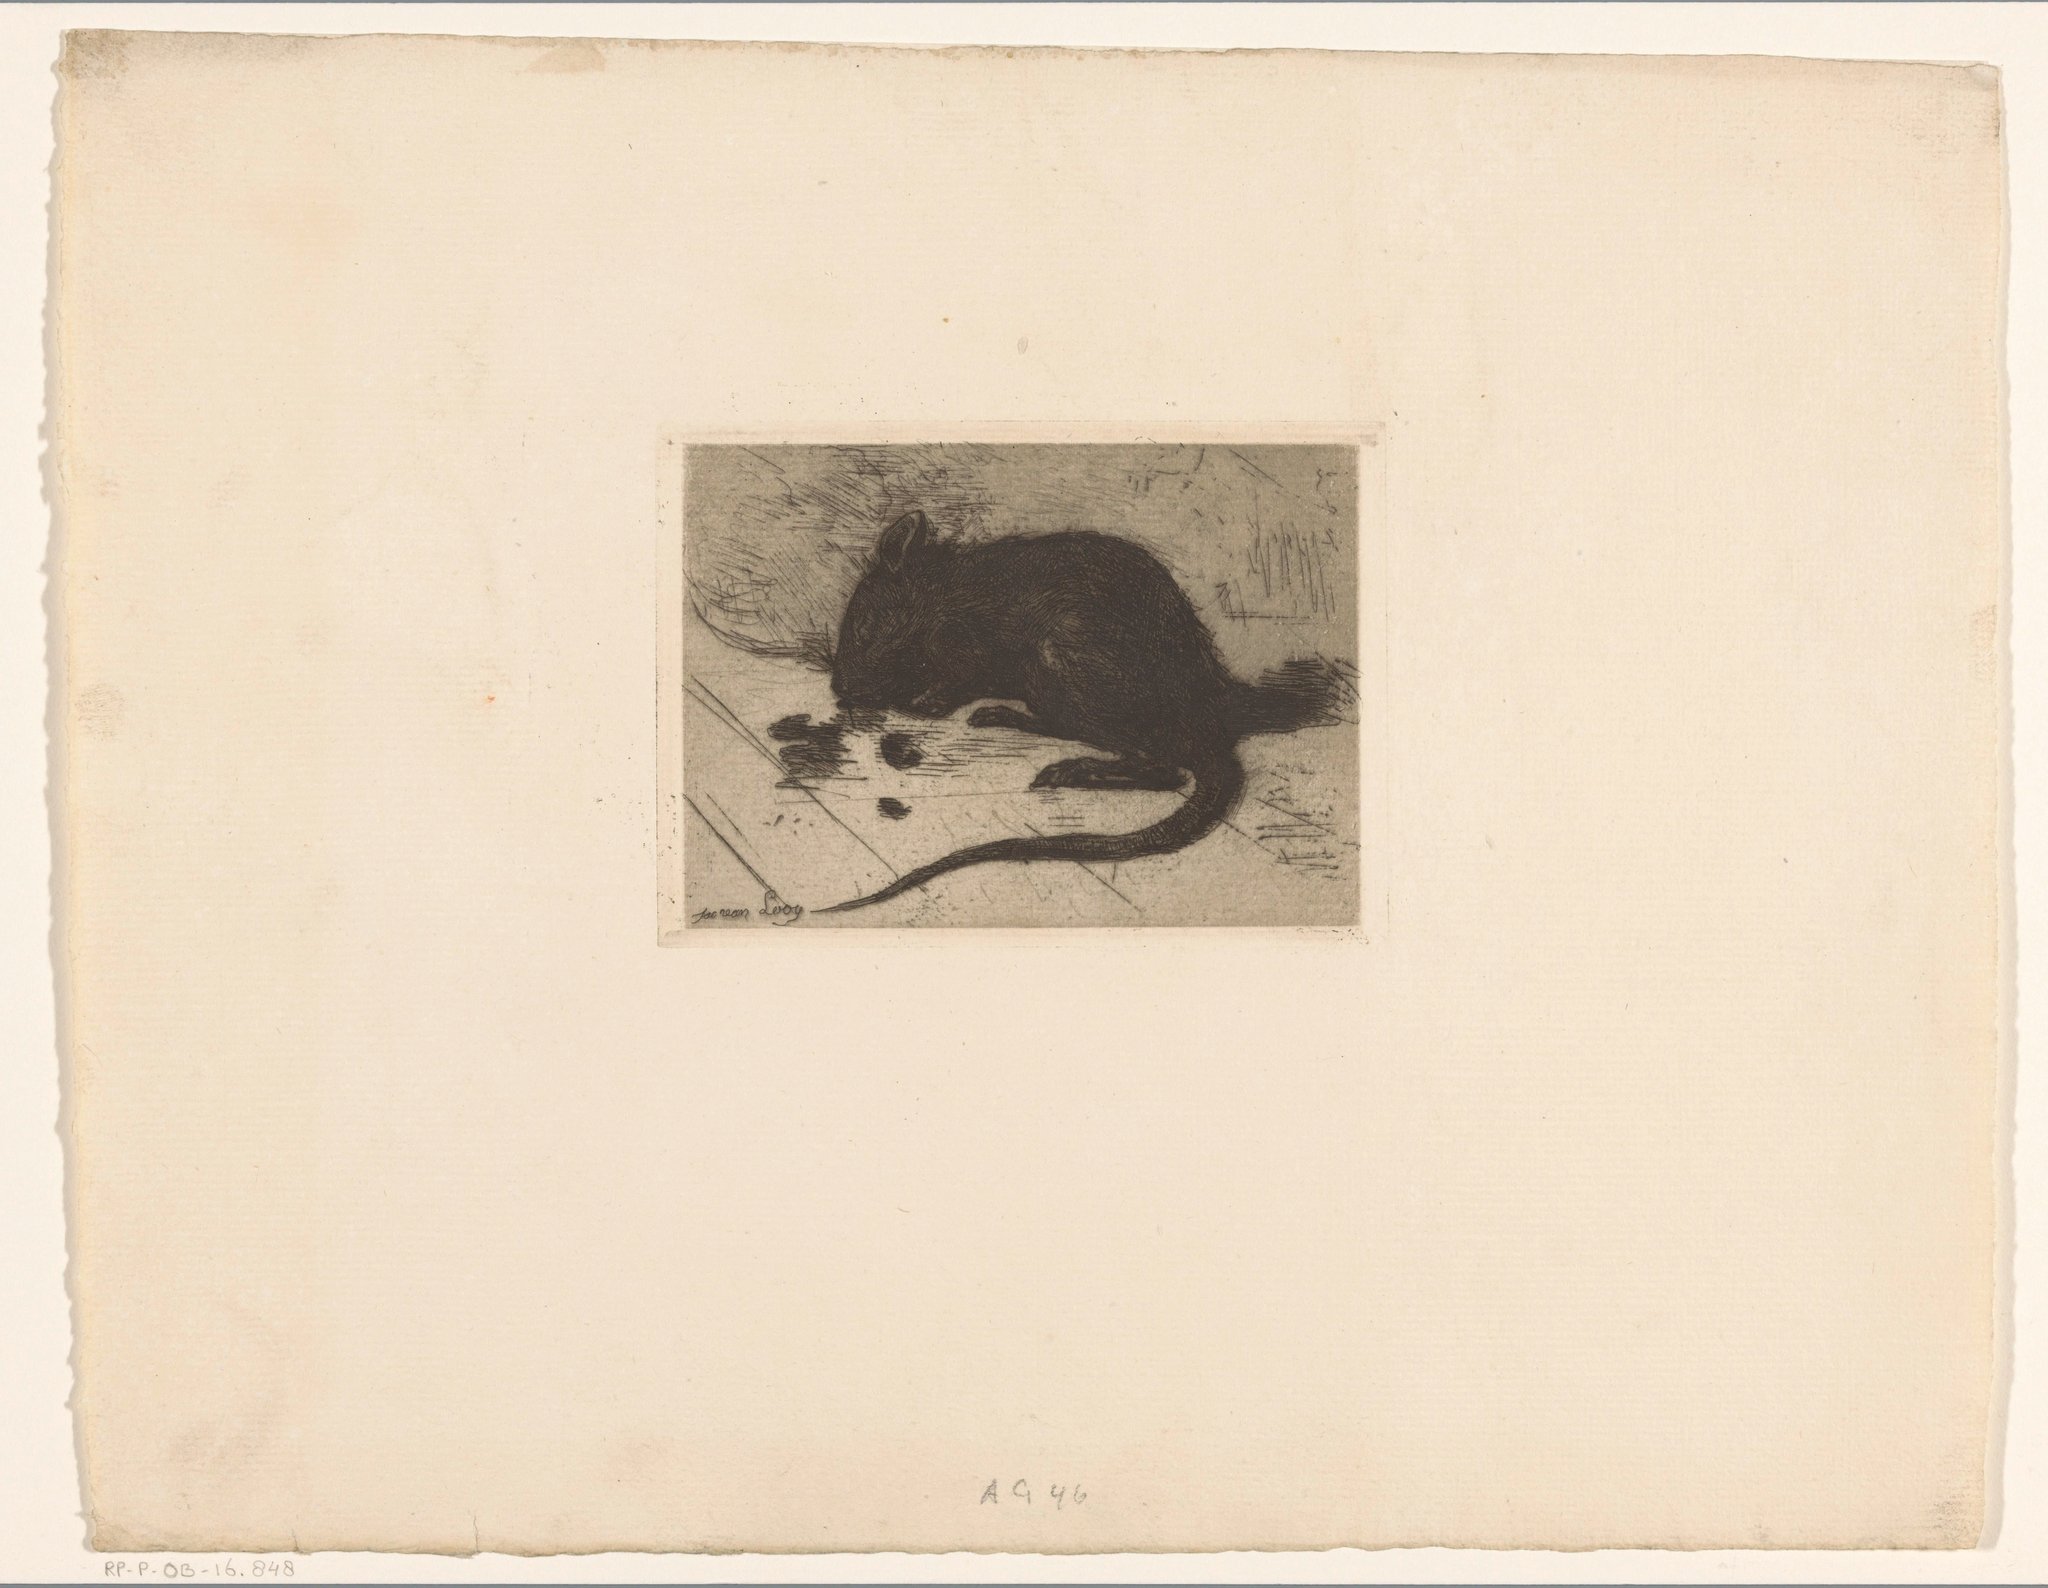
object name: print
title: Muis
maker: jac van looij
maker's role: draughtsman, painter, print maker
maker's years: 1855-1930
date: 1865-1930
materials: paper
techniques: etching, intaglio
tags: rodents: mouse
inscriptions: collector's mark: Lugt 2228